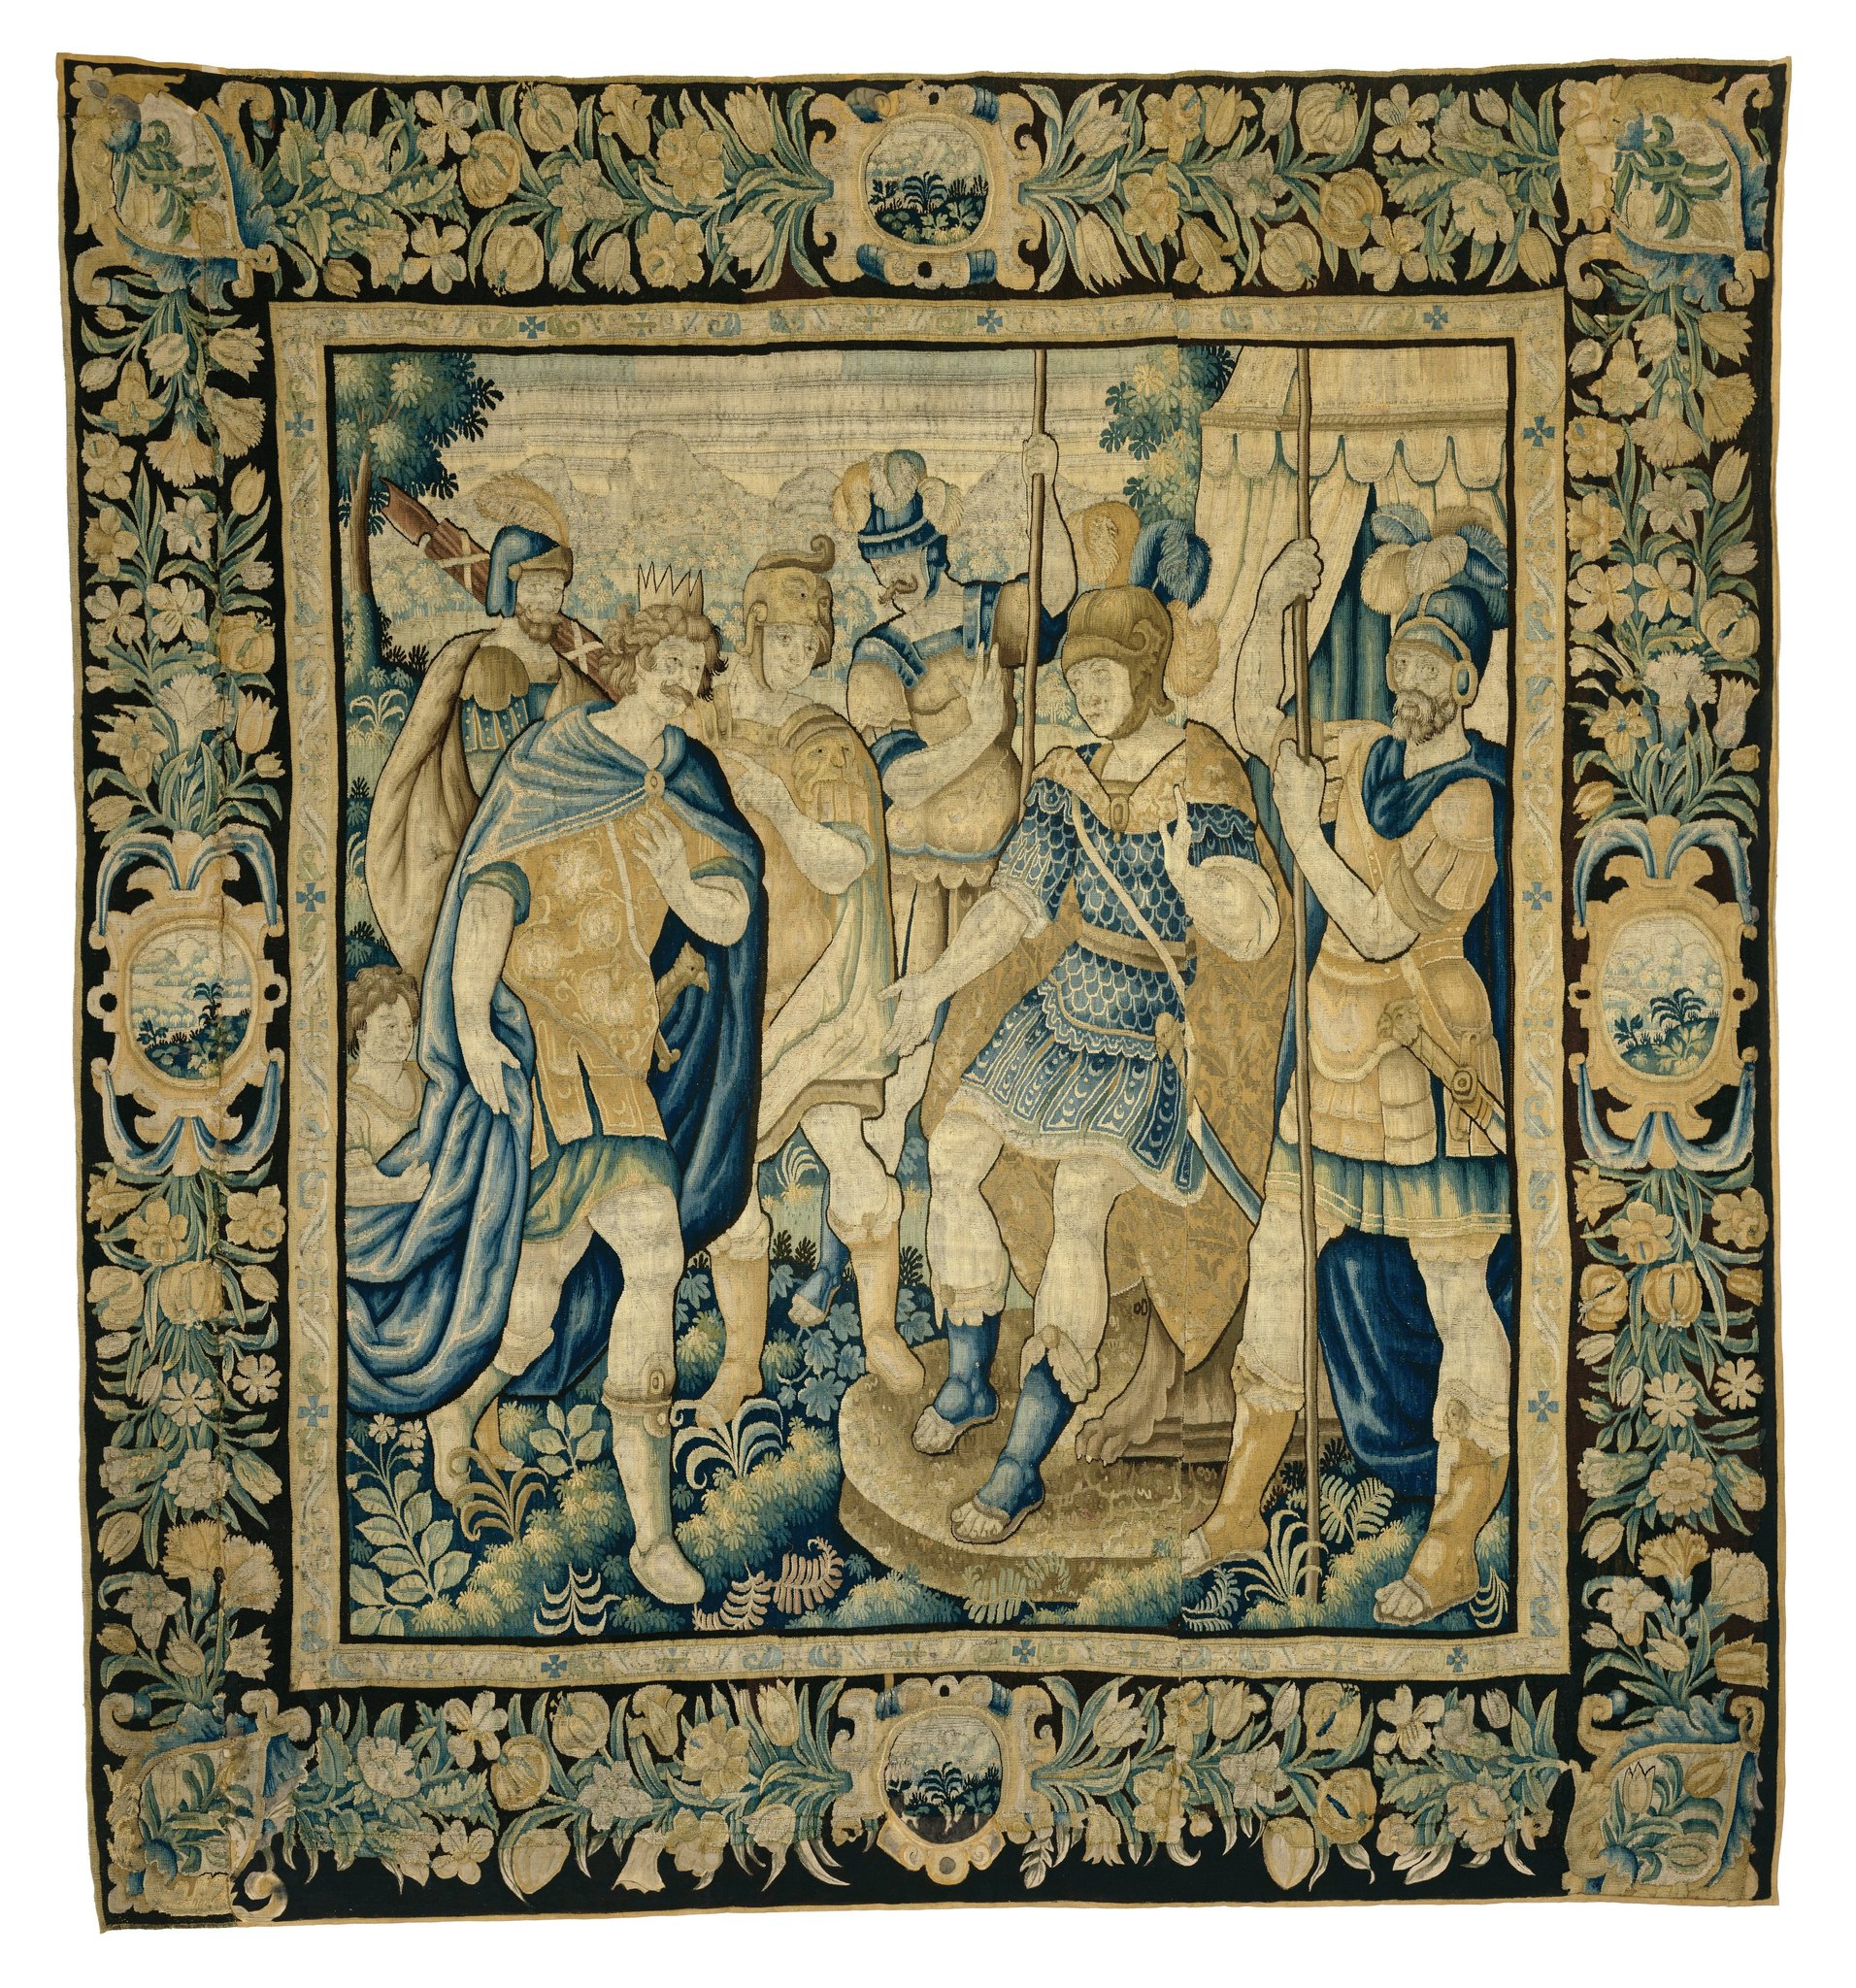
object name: tapestry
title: De geschiedenis van Alexander de Grote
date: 1625-1650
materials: silk, wool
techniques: tapestry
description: Wandtapijt met koning Porus (?) Alexander bezoekend, uit een serie met de geschiedenis van Alexander de Grote.